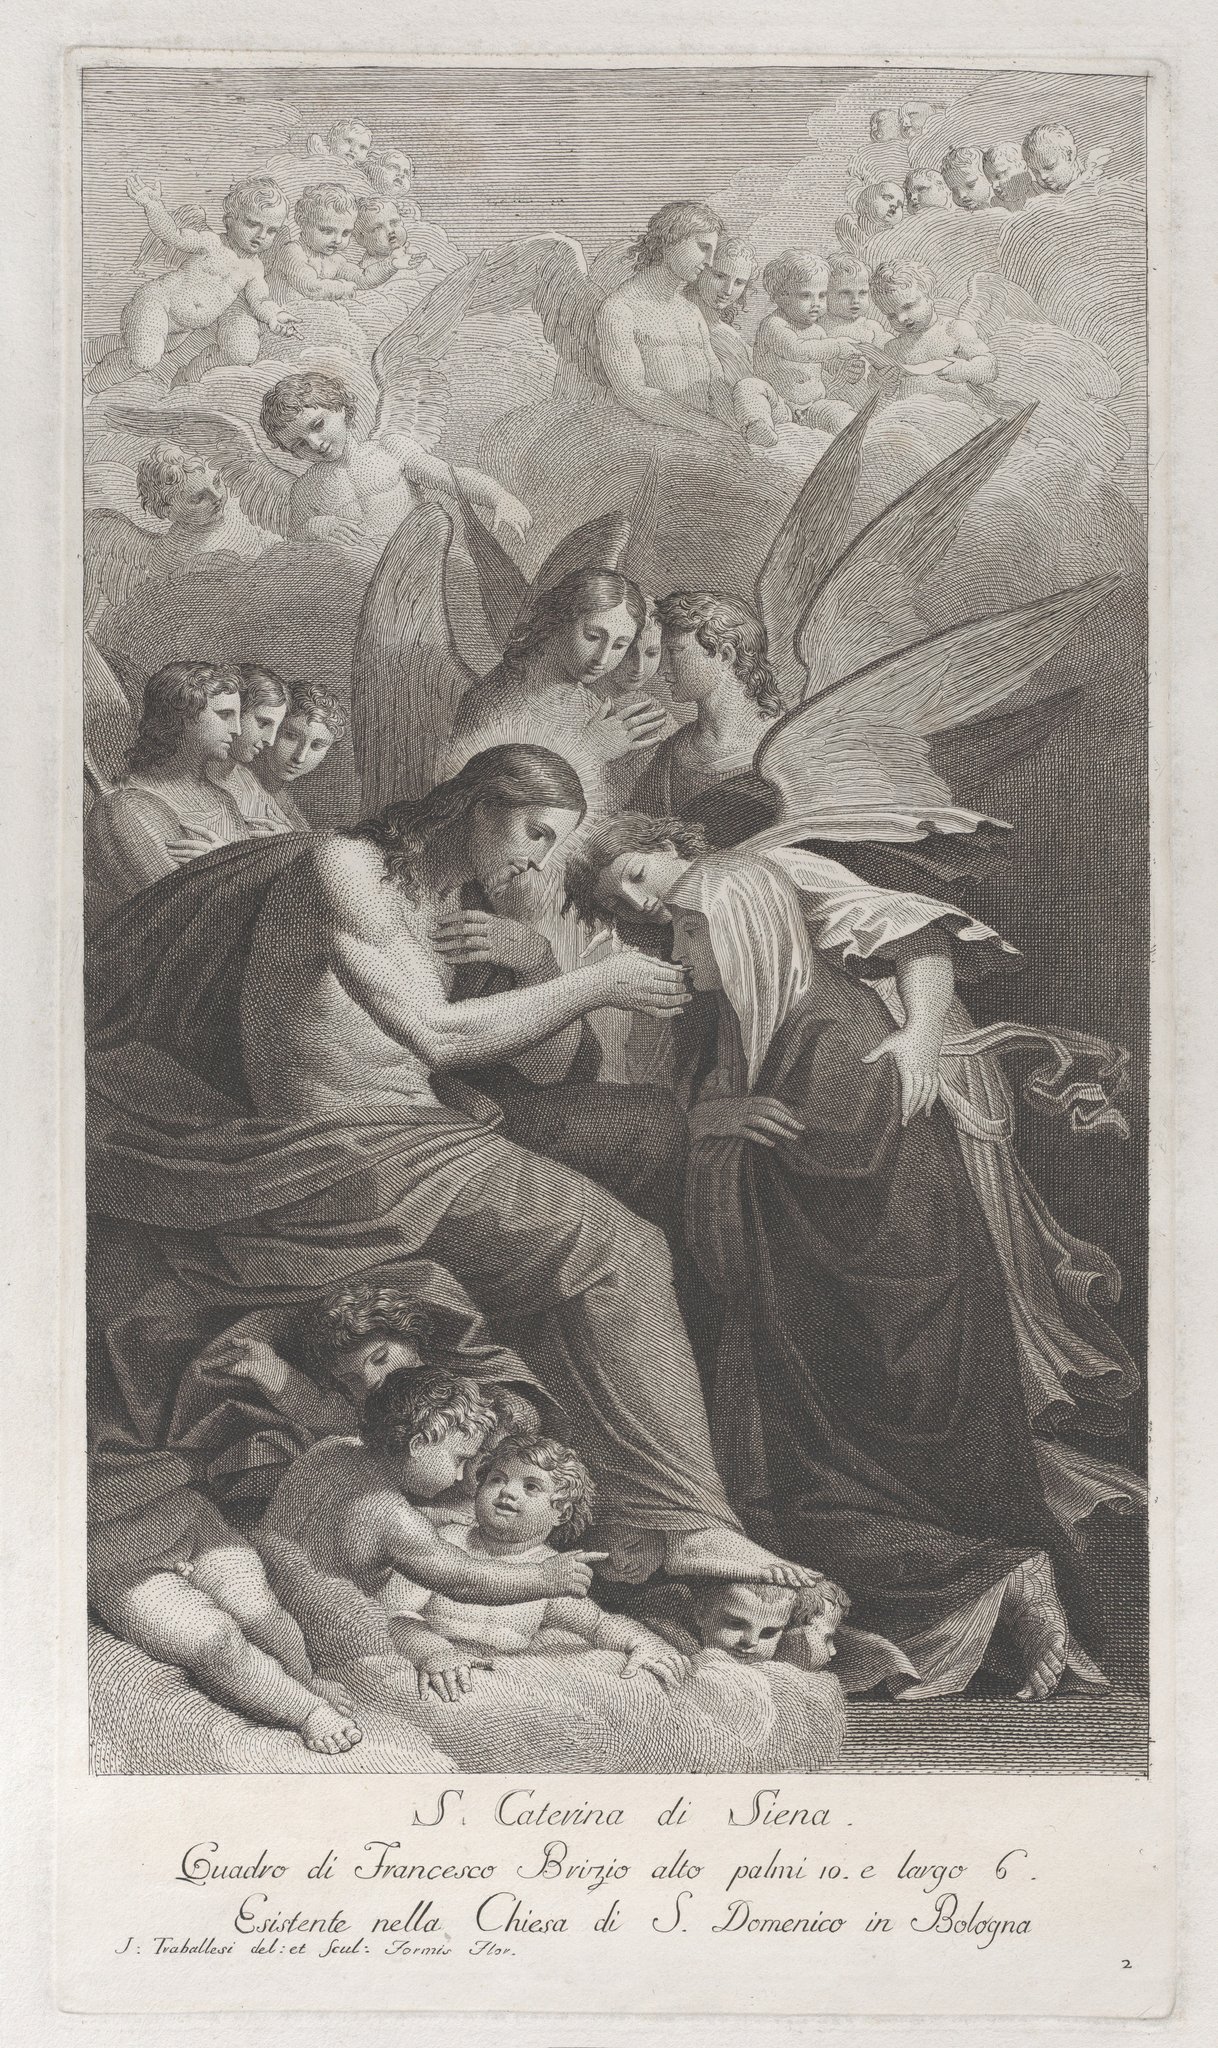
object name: print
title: Christ giving the Sacred Host to the kneeling Saint Catherine of Siena, surrounded by various angels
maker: giuliano traballesi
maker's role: artist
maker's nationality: italian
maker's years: 1727-1812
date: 1750-1812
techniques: etching